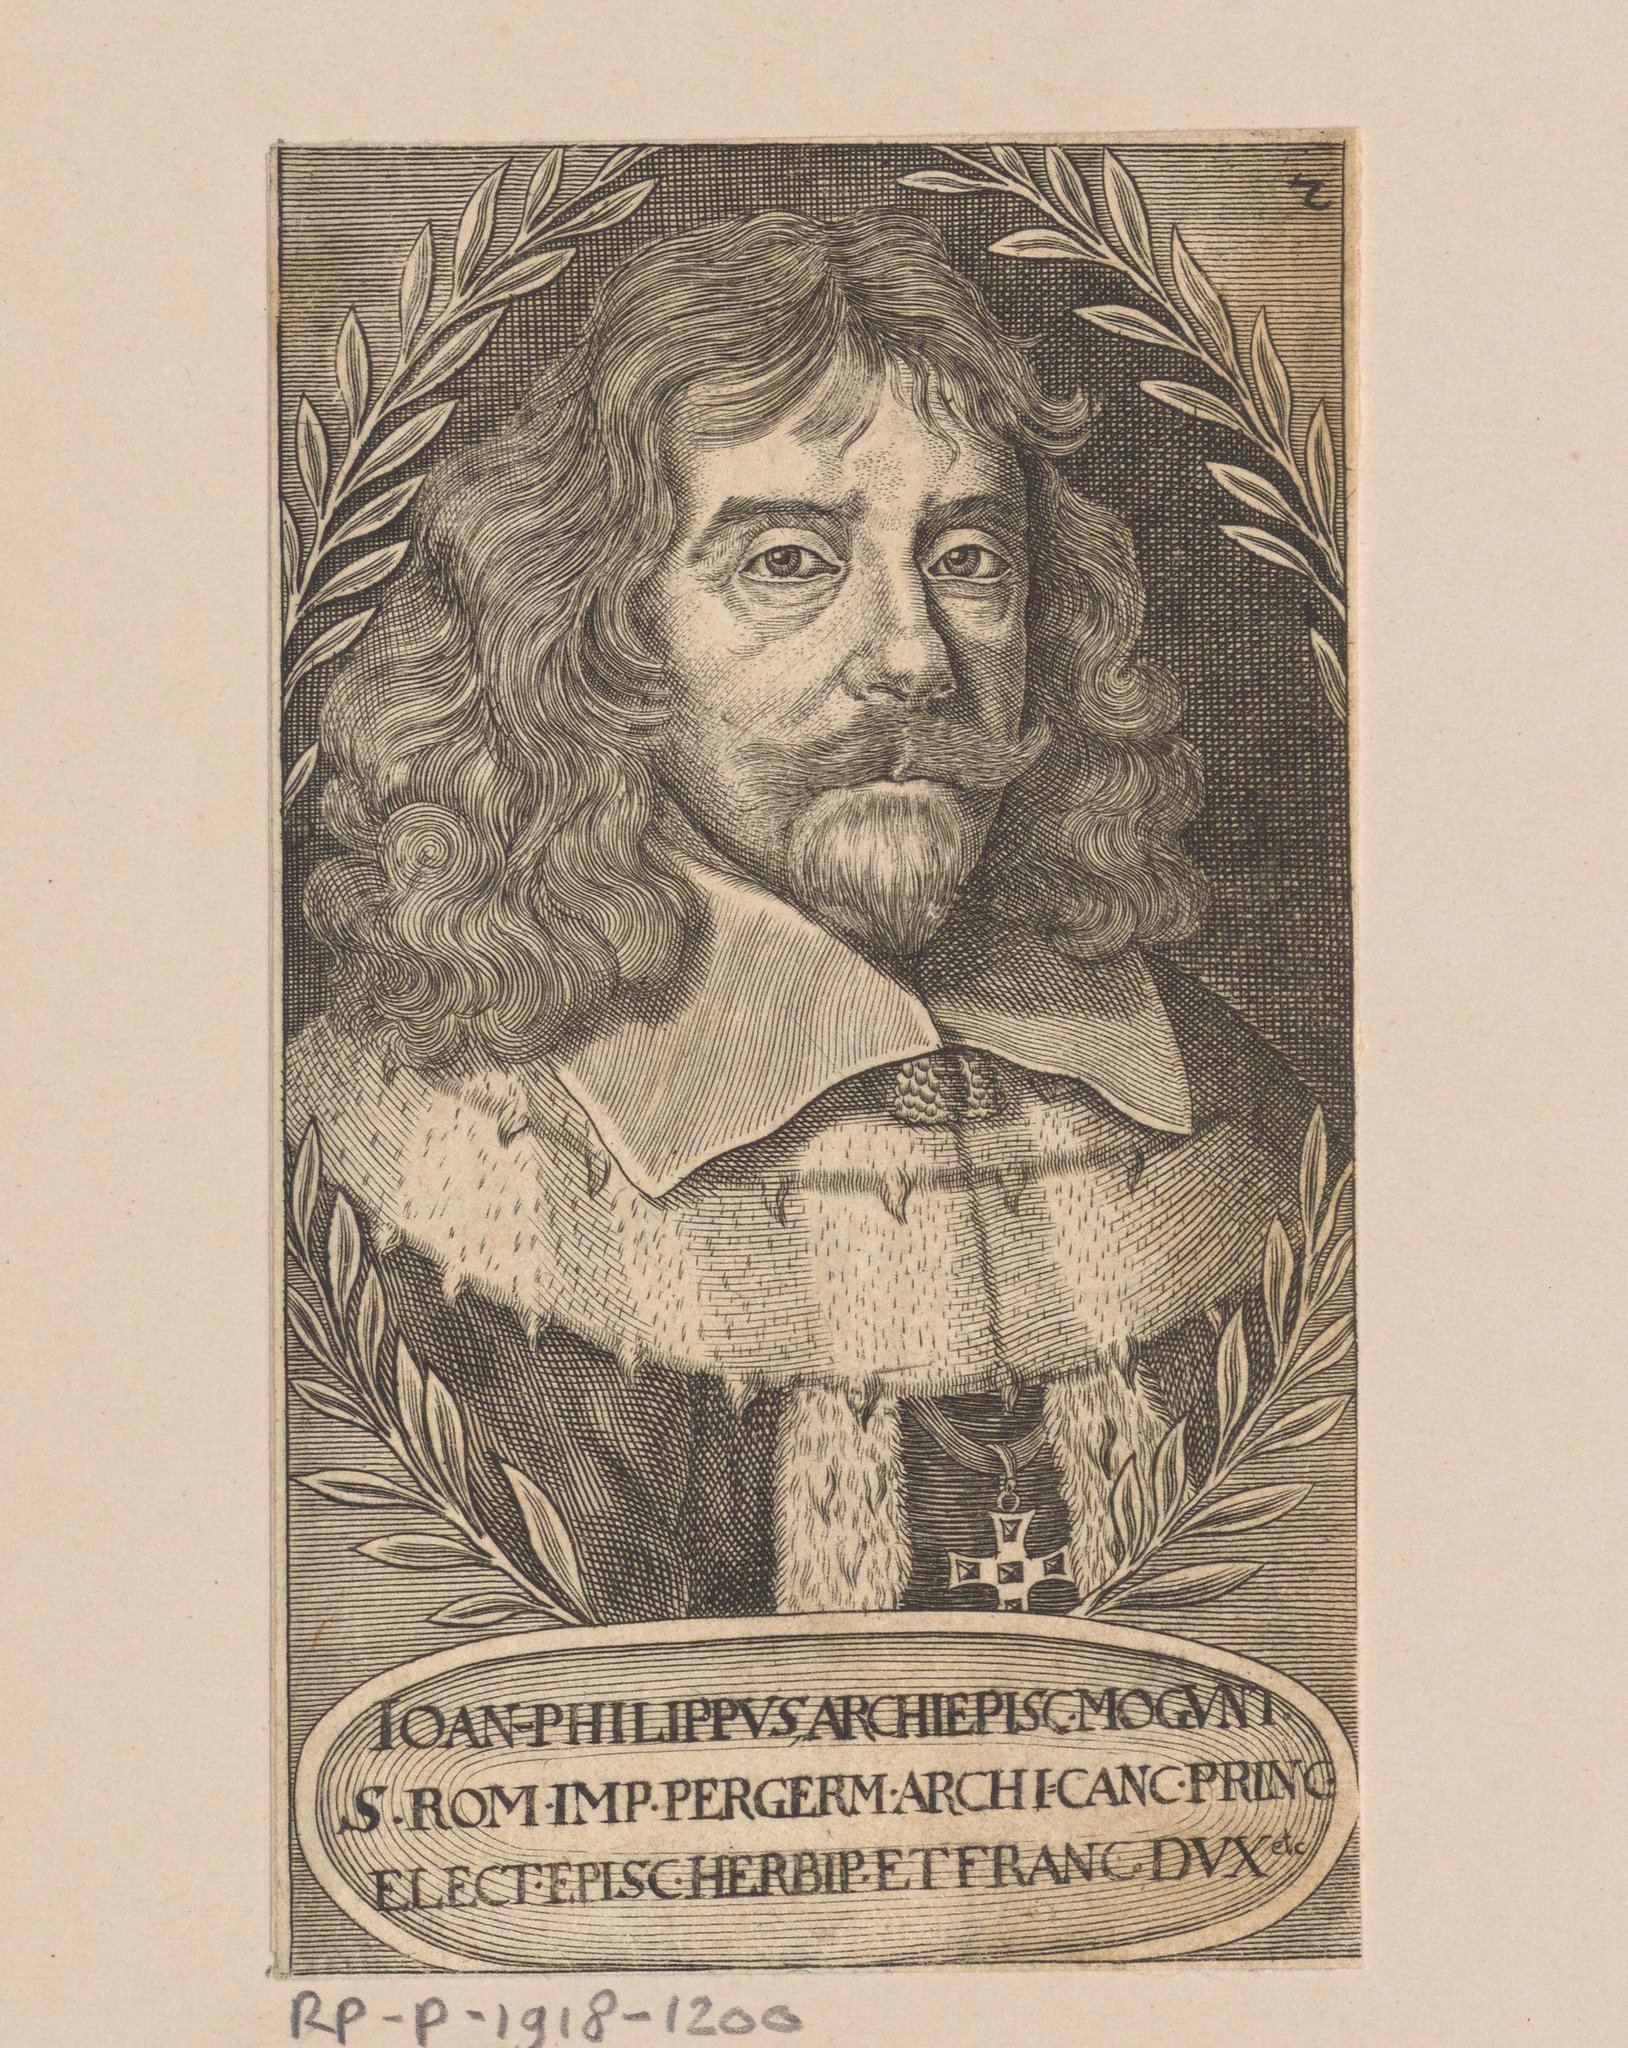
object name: print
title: Portret van Johann Philipp von Schönborn, aartsbisschop van Mainz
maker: Anonymous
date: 1647-1699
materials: paper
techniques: engraving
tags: archbishop, bishop, etc. (roman catholic), historical persons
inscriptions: collector's mark: Lugt 2233